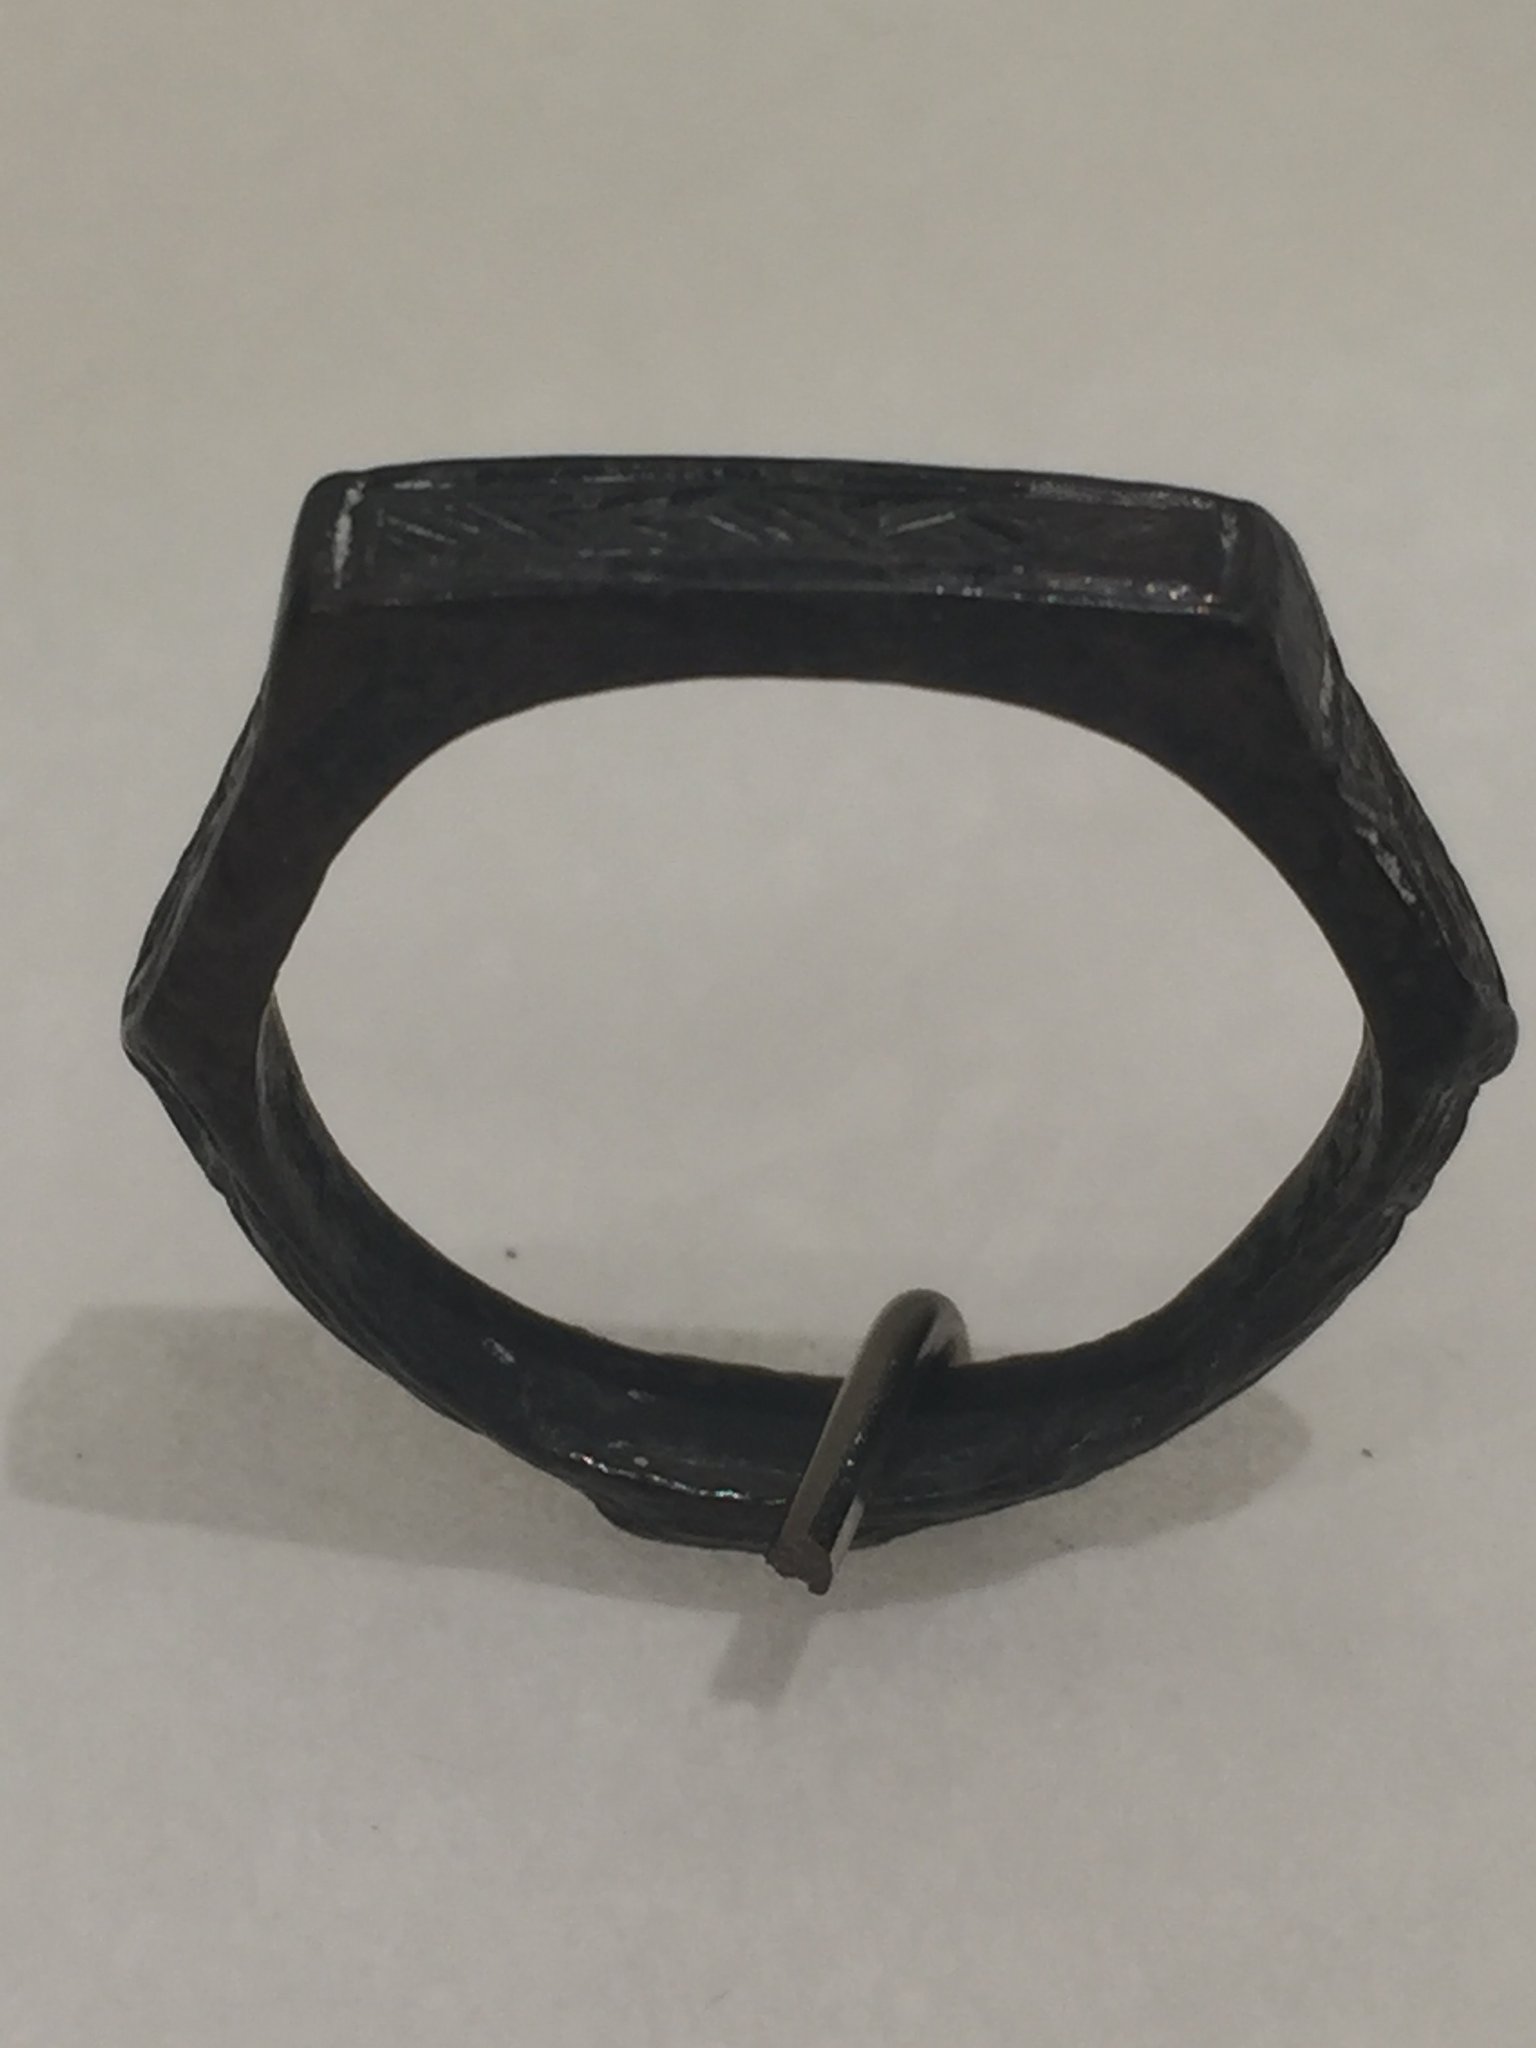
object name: ring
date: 201-1200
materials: silver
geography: egypt